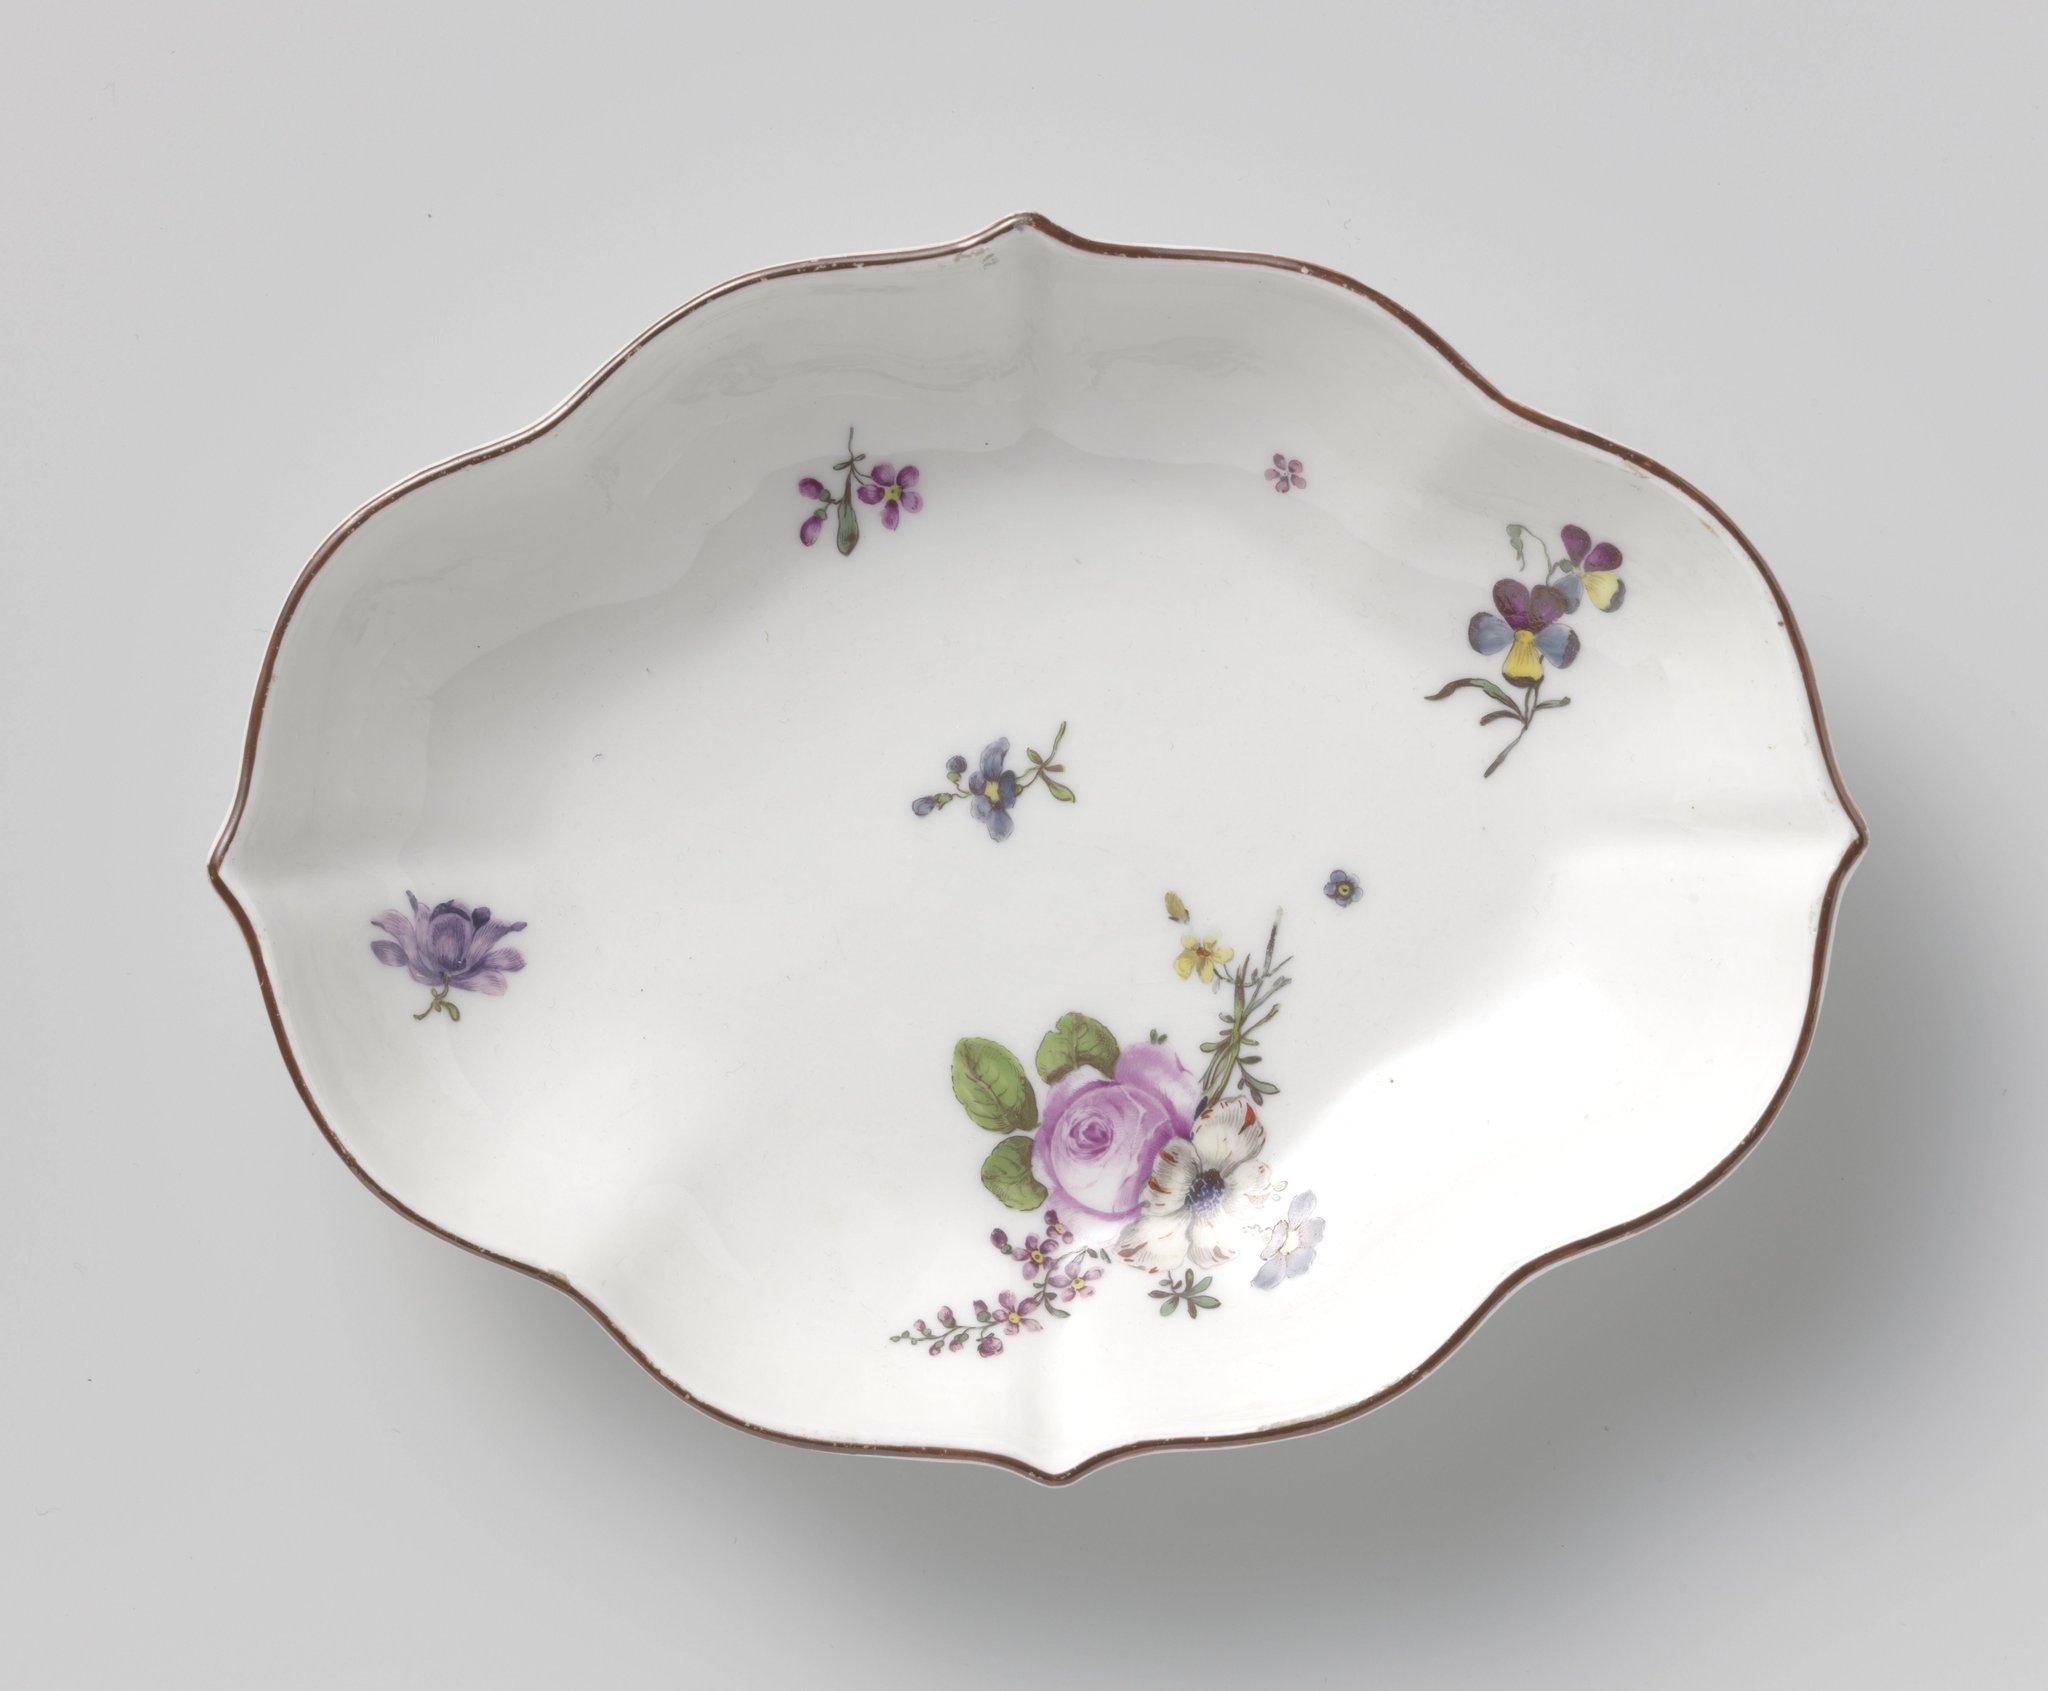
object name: dish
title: Schaal of pattipan, veelkleurig beschilderd met bloemboeketten en strooibloemen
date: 1750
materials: porcelain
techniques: painted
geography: meissen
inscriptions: mold mark: ‘30’, factory mark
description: Schaal van beschilderd porselein. De schaal heeft accoladevormige geschulpte randen en is beschilderd met veelkleurige bloemboeketten en strooibloemen. De rand is bruin gekleurd. De schaal is gemerkt.